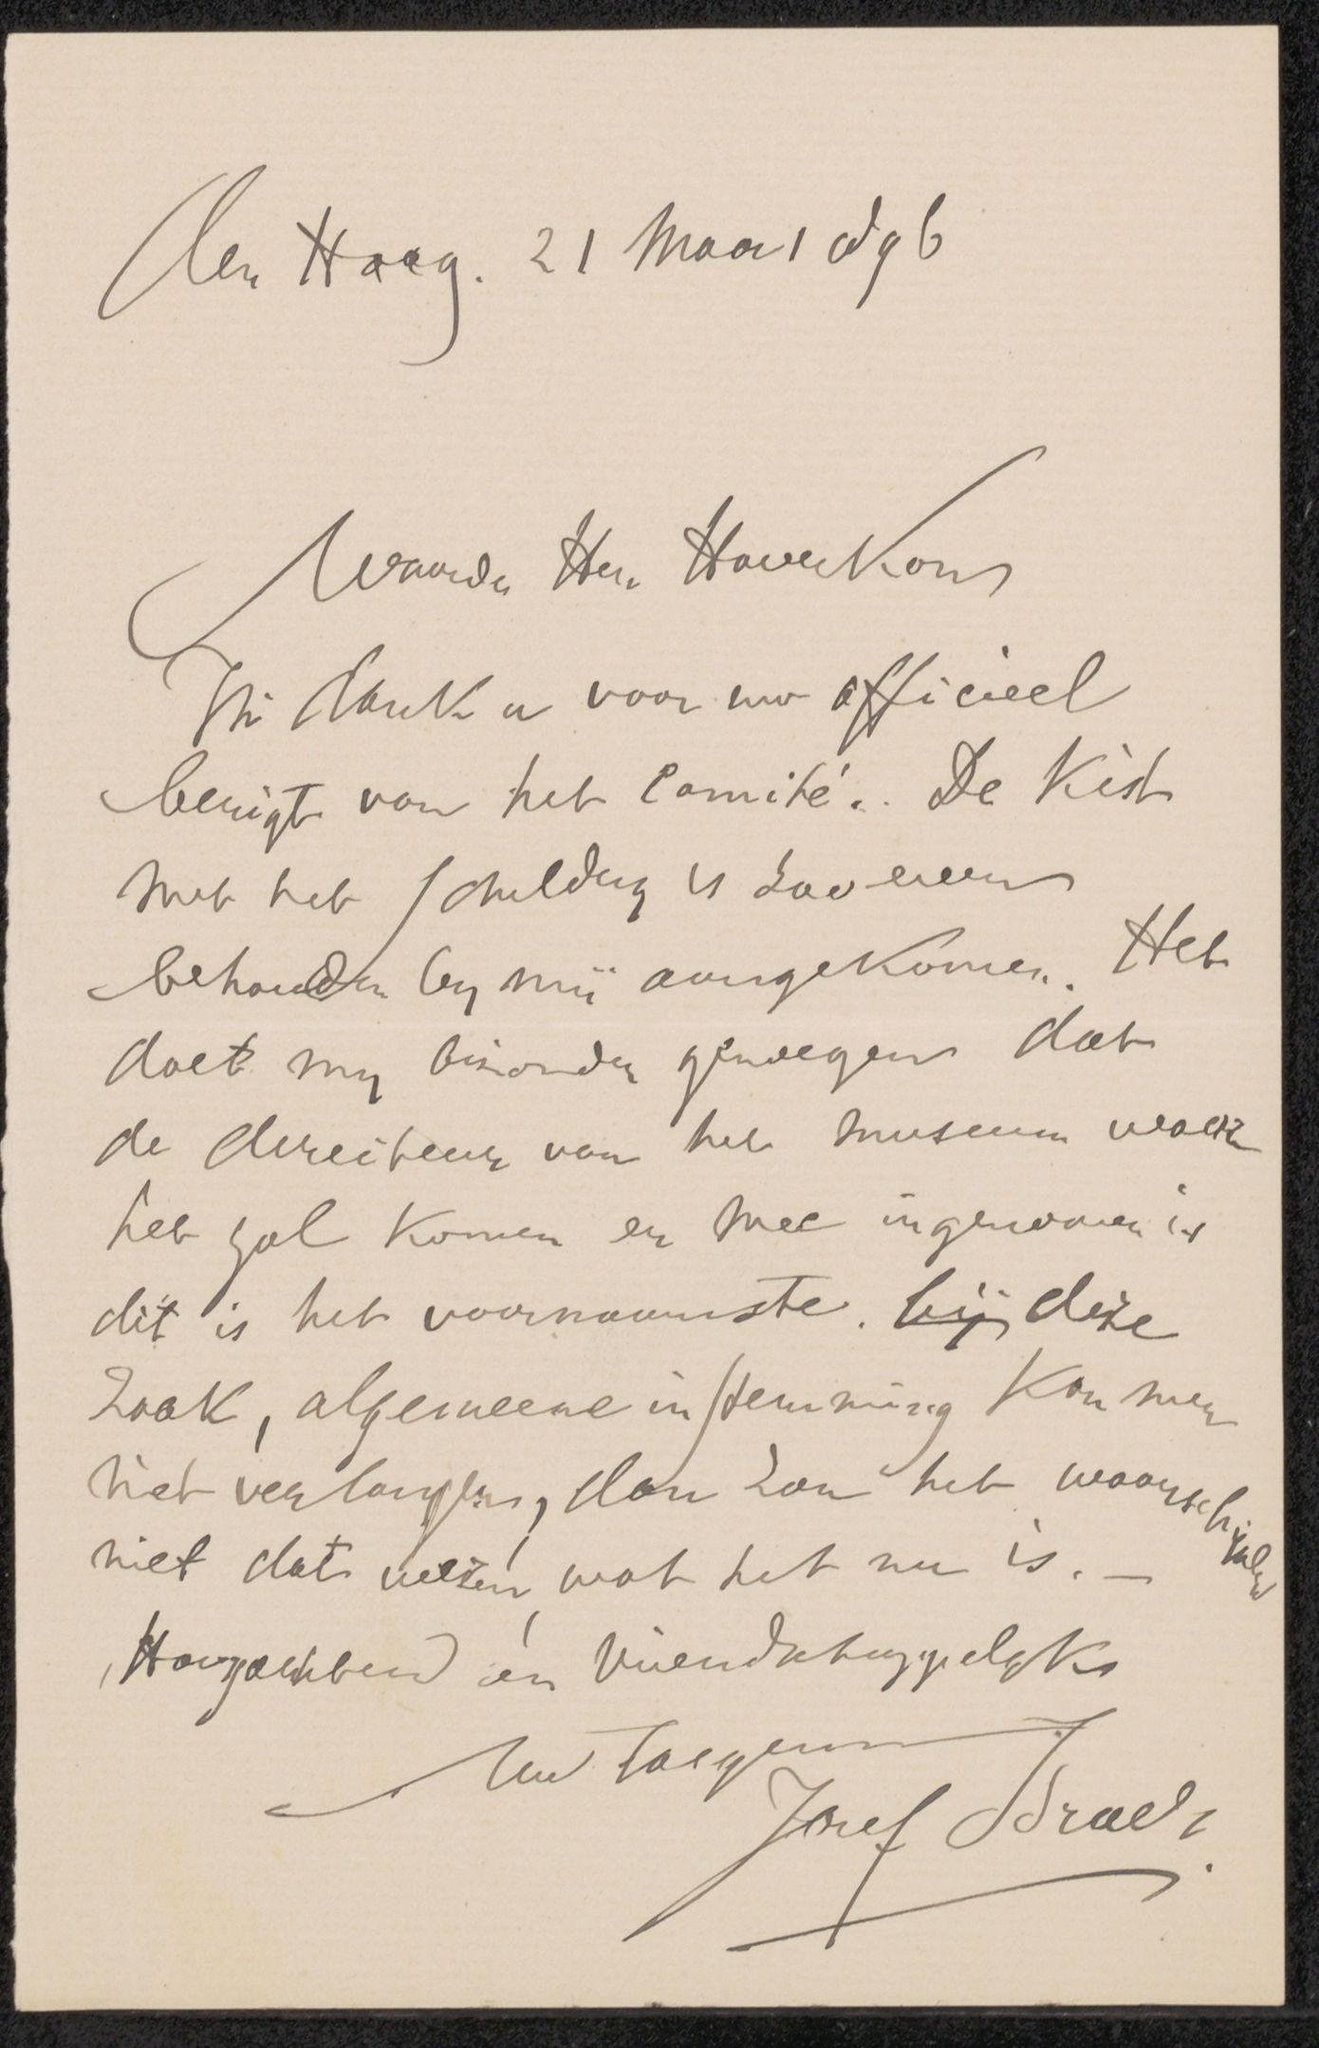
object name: letter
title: Brief aan Pieter Haverkorn van Rijsewijk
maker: jozef israëls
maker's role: draughtsman, painter, print maker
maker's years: 1824-1911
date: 1896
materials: ink, paper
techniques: pen, writing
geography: the hague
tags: pieter haverkorn van rijsewijk, painting (including book-illumination, miniature-painting)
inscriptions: collector's mark: ‘RPK’